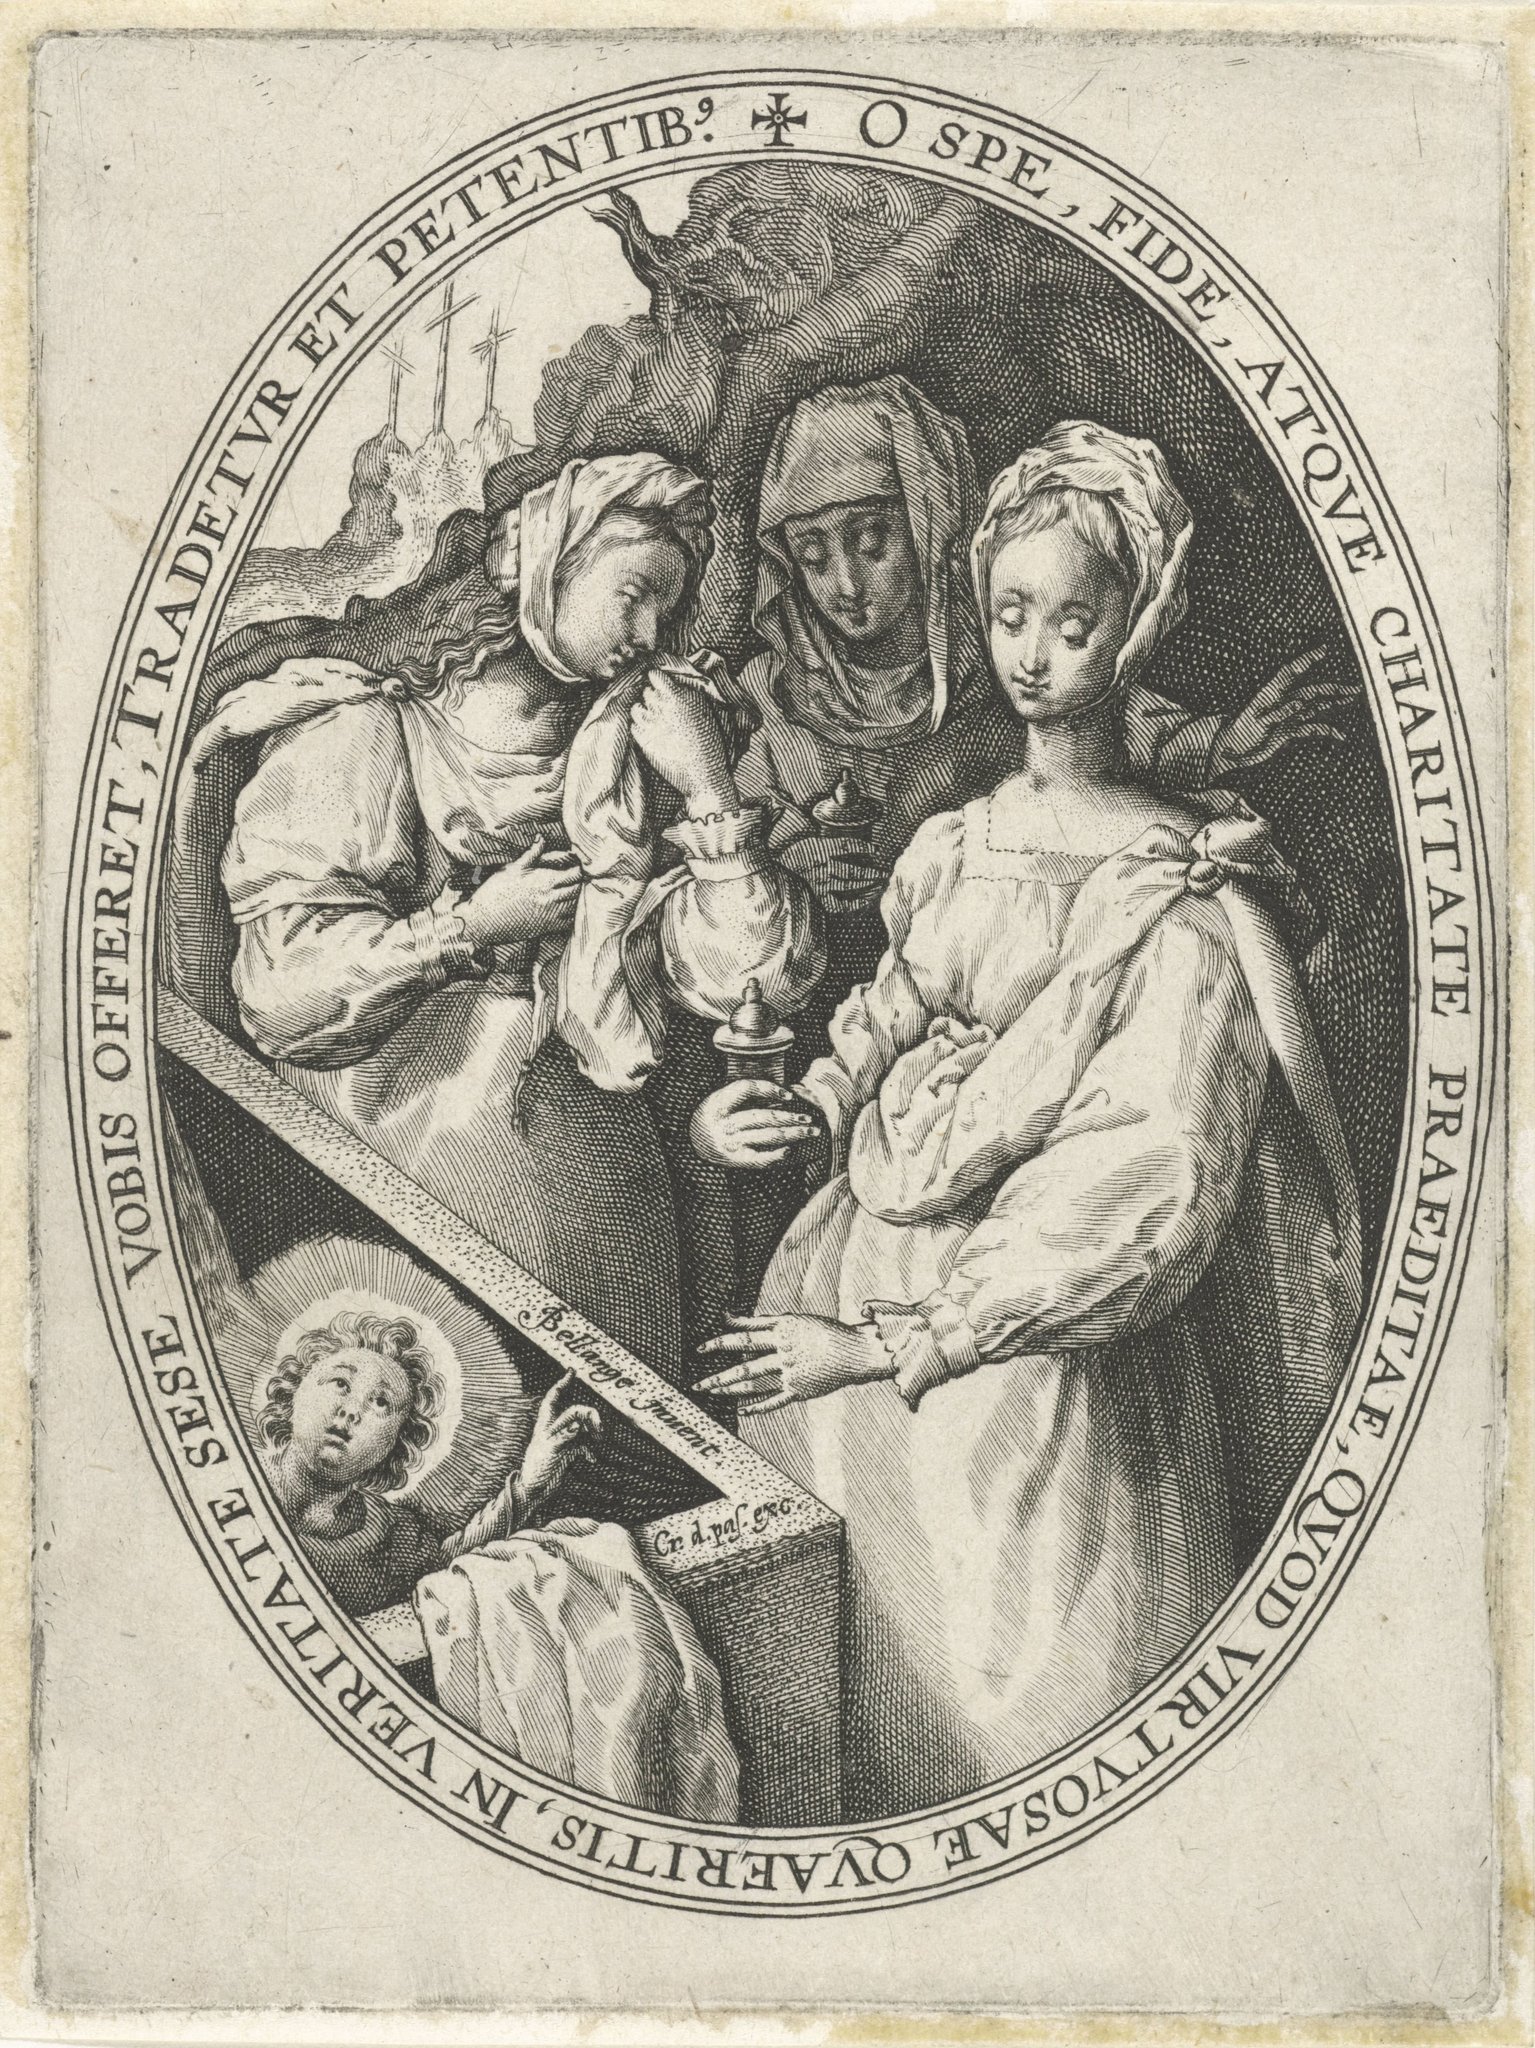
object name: print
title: Passie van Christus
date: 1600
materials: paper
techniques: engraving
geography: cologne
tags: angel(s) addressing the holy women ~ resurrection of christ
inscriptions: collector's mark: Lugt 2542, collector's mark: Lugt 2228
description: Bij het graf van Christus verschijnt een engel aan de drie heilige vrouwen die Christus kwamen zalven. Twee van hen hebben een zalfpot in de handen. Op de achtergrond de drie kruizen. De voorstelling is gevat in een ovale omlijsting met een randschrift in het Latijn. Prent uit een serie met de passie van Christus.